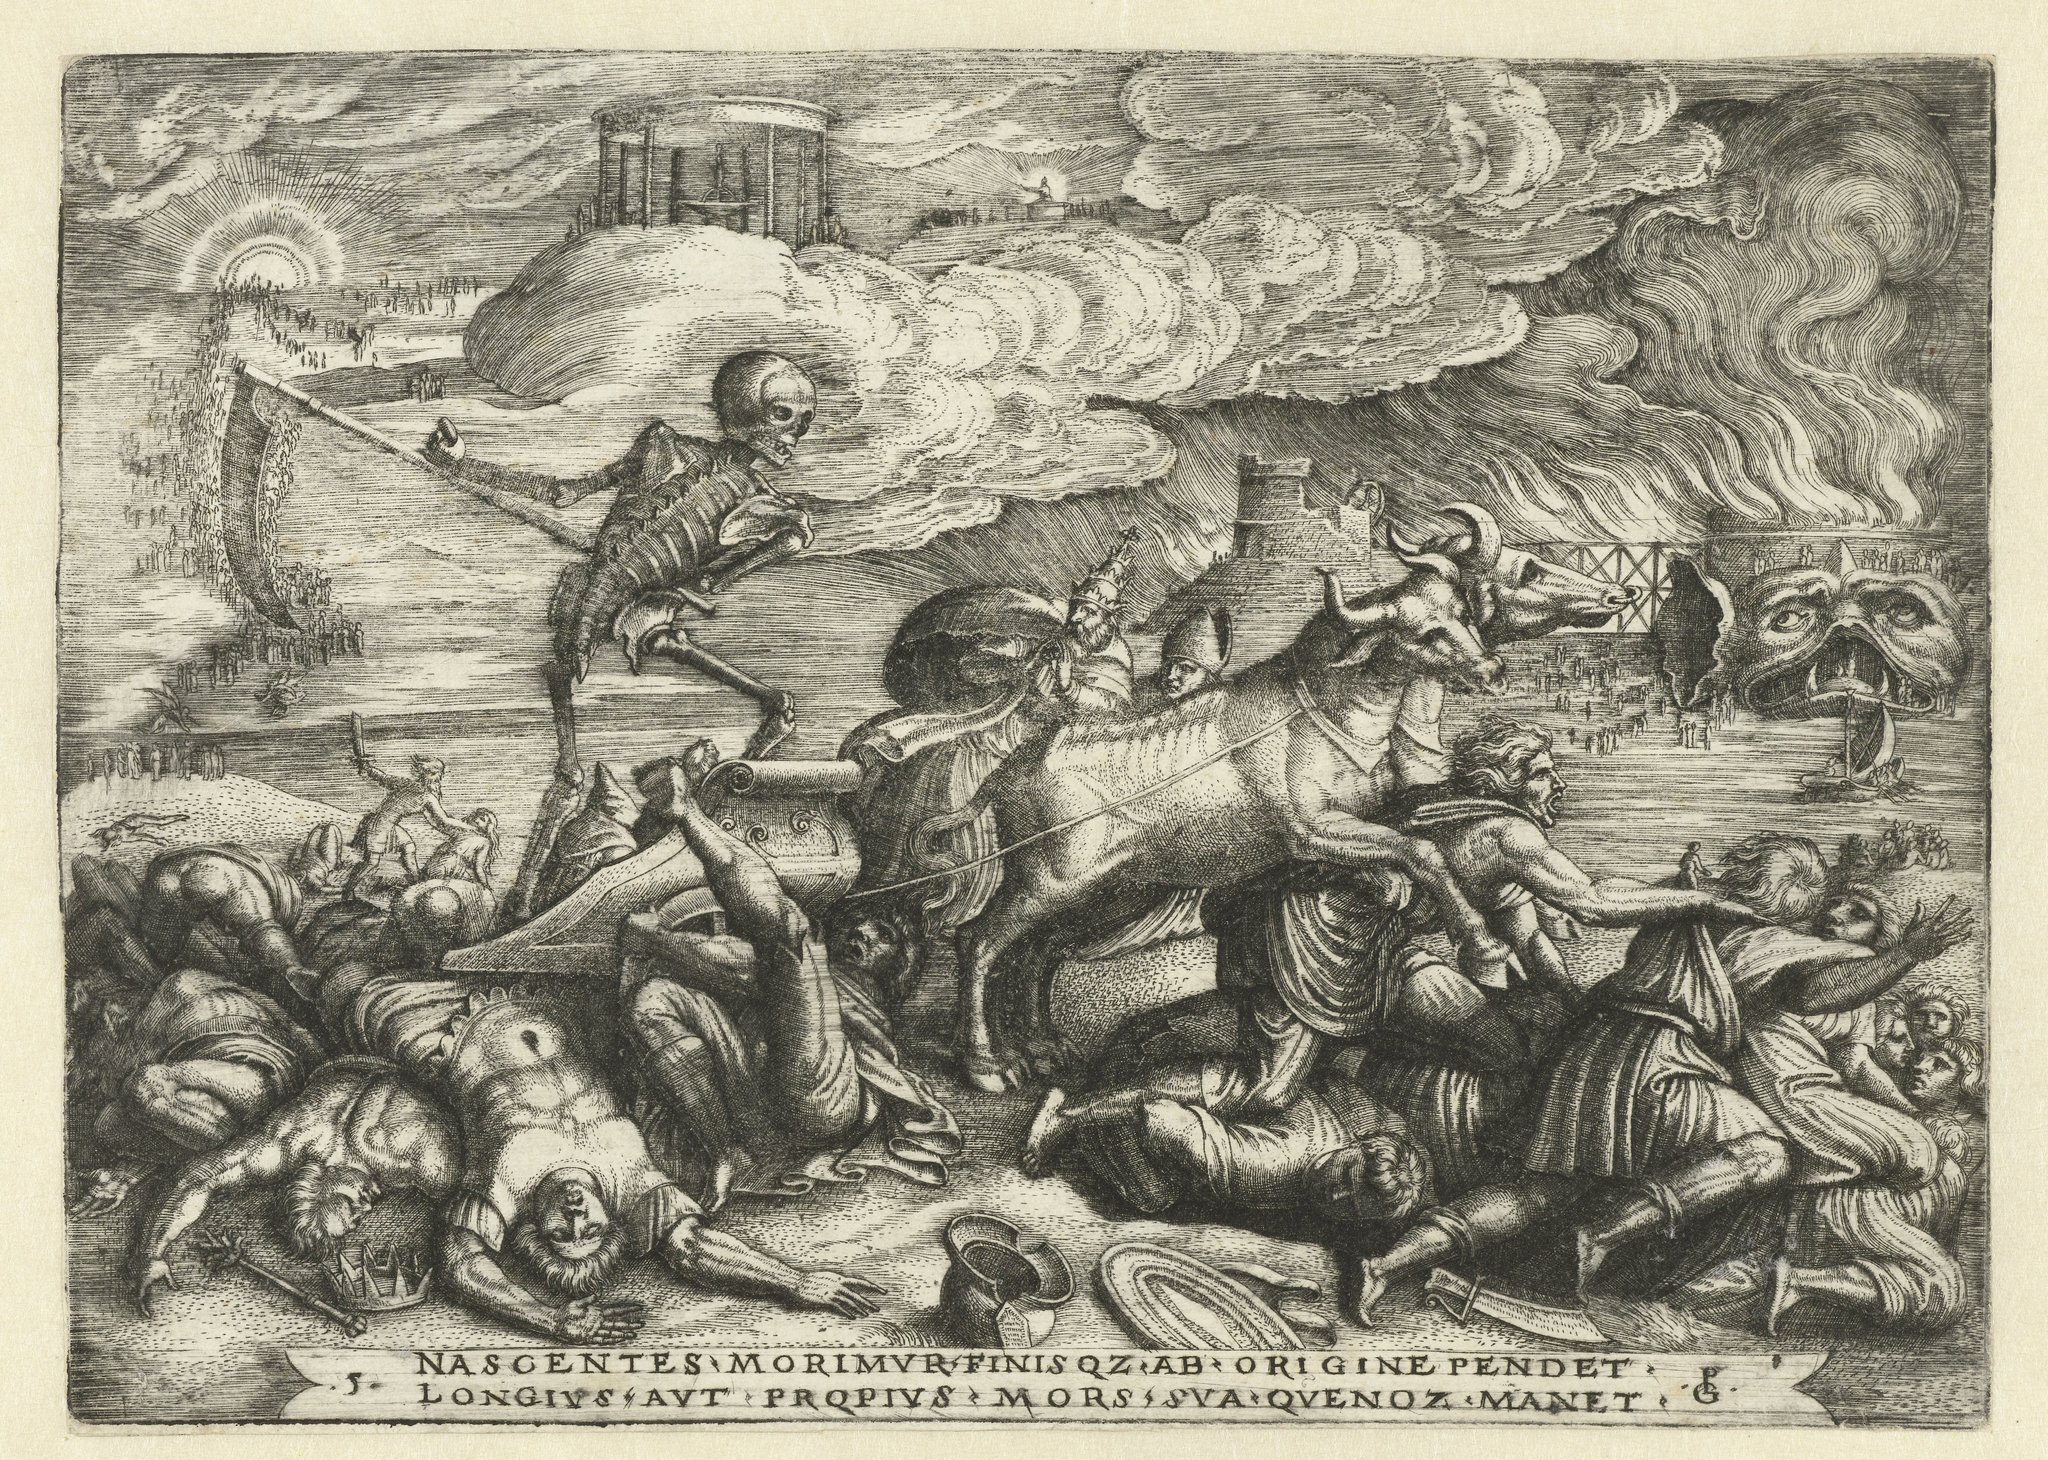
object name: print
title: Triomf van de Dood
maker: georg pencz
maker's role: draughtsman, painter, print maker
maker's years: 1500-1550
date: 1537-1541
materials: paper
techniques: engraving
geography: germany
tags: 'trionfo della fama', 'triumphus famae'; 'carro della fama' (ripa)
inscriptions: collector's mark: Lugt 2228a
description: Een geraamtemet een zeis, dat de Dood verbeeld, staat op een wagen, die getrokken wordt door twee ossen. De doden en stervenden worden verpletterd onder de wielen van zijn wagen. Twee geestelijken bidden voor de zielen. Op de achtergrond ligt de bestemming van deze zielen, ze gaan naar de hel met de grote hellemond en het vagevuur of de hemel. Latijns opschrift in twee regels: NASCENTES MORIMVR FINIS ... SVA QUENOZ MANET